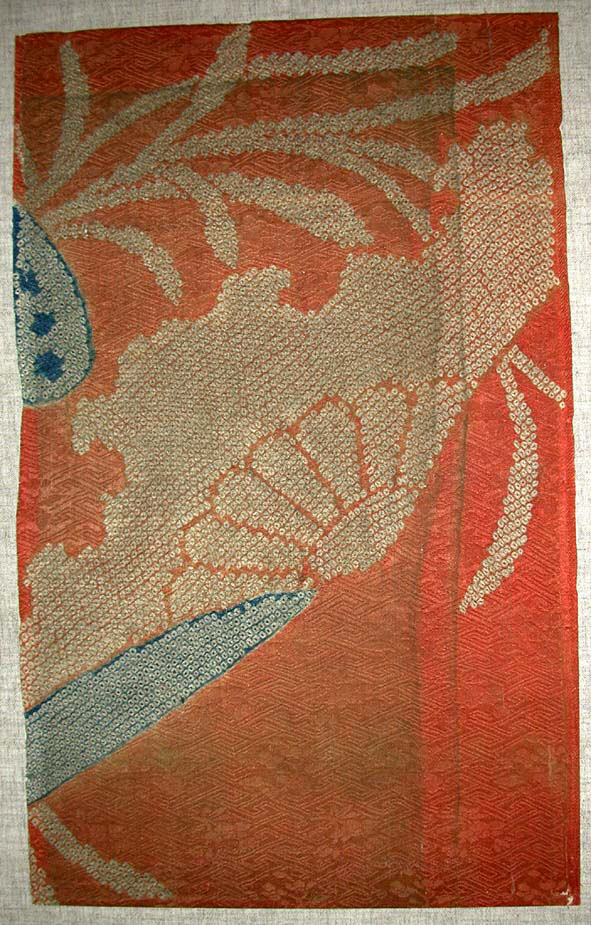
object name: piece from a kosode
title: Kosode Fragment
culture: japanese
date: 1651-1700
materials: textile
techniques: damask